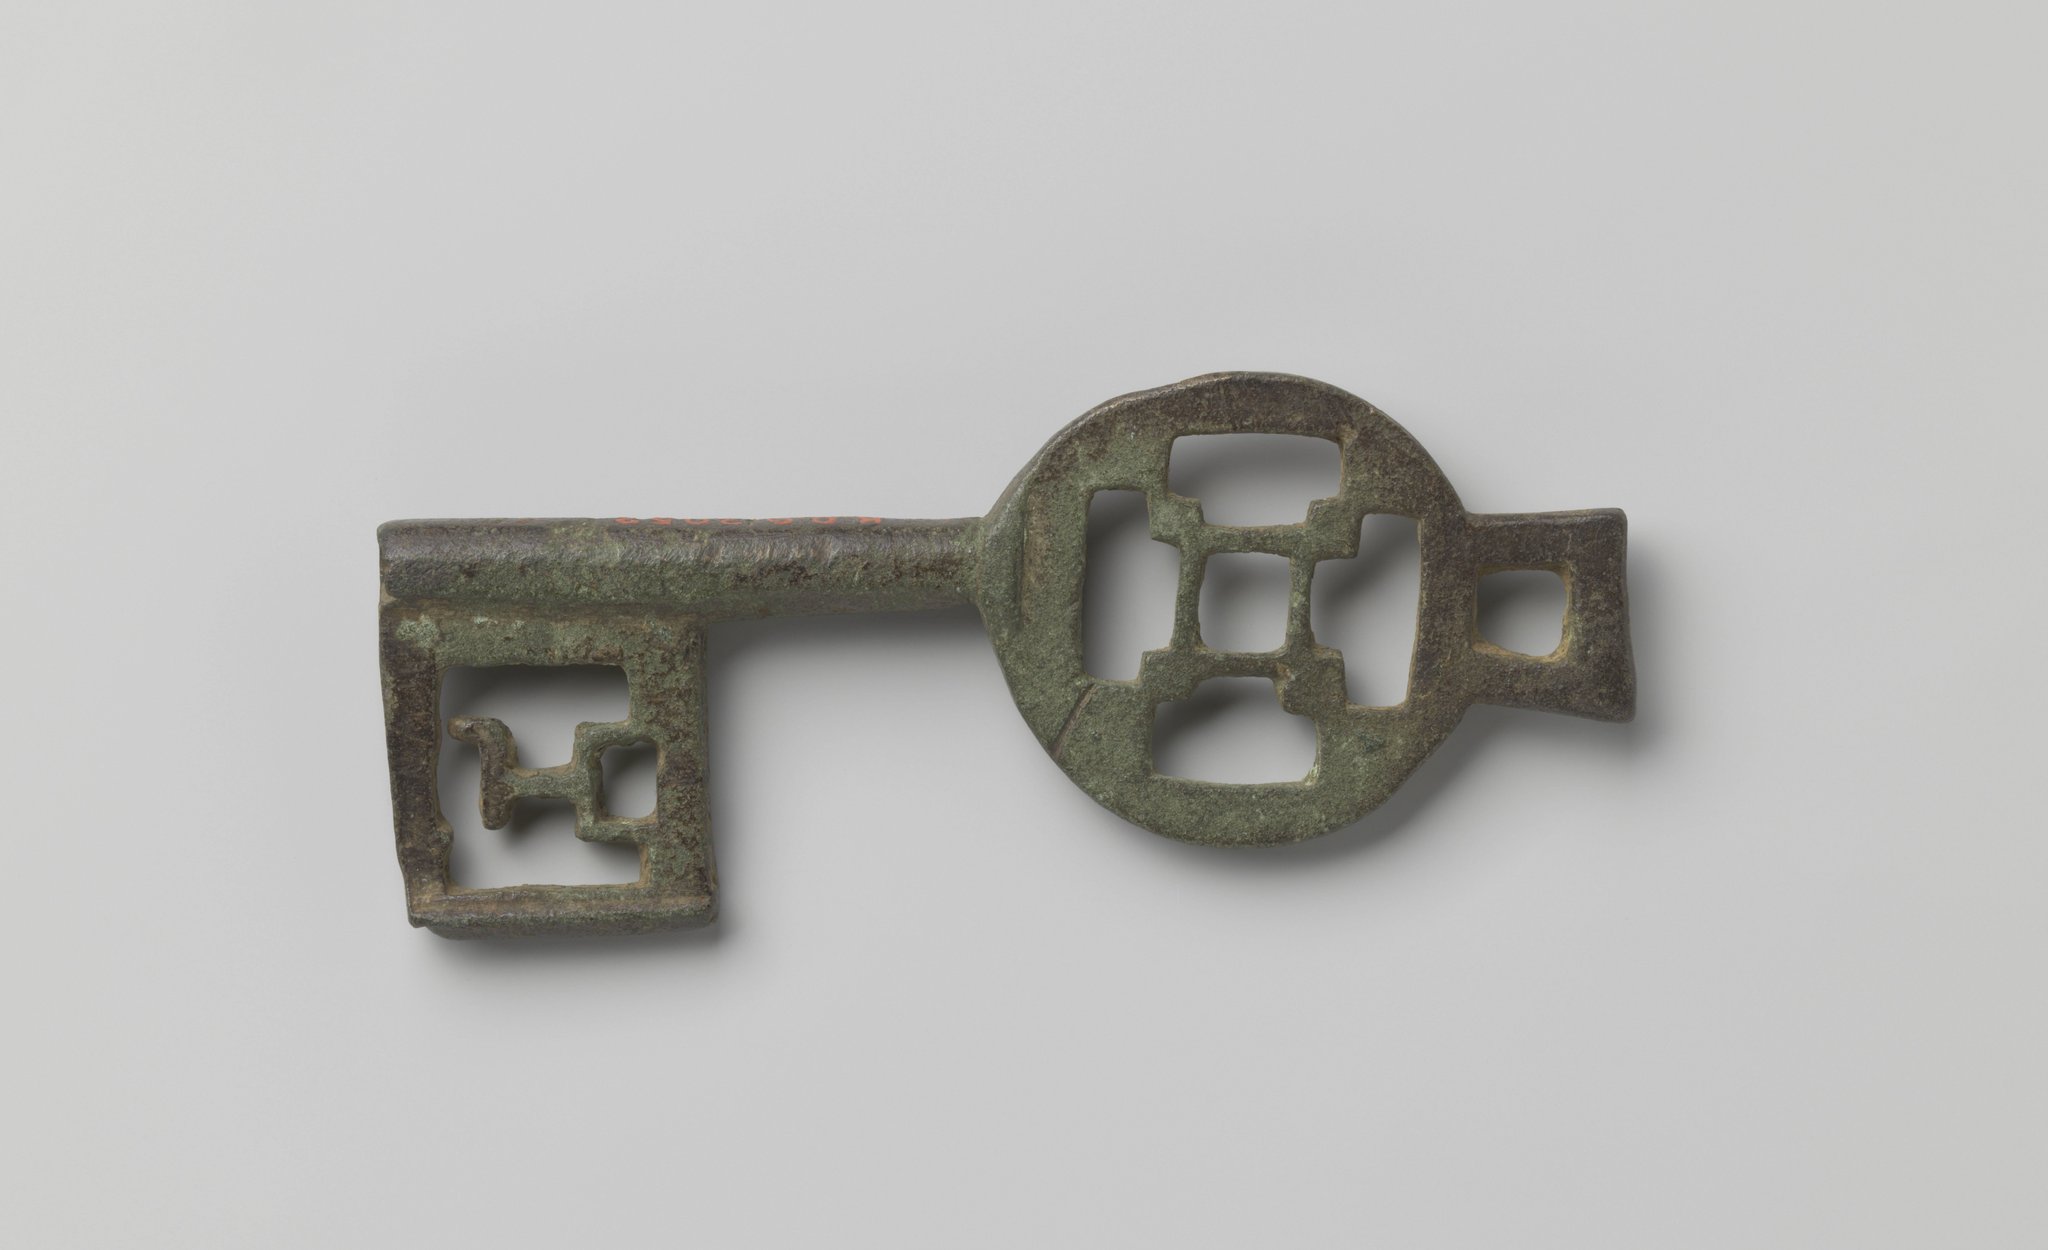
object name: key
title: Pijpsleutel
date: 1400-1950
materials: bronze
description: Pijpsleutel, zgn. "bisschopssleutel" met cirkelvormige greep, waarin een gestileerd kruis is uitgehakt en waarop zich een vierkant oog bevindt. De steel is achthoekig, de baard vierkant en opengewerkt.